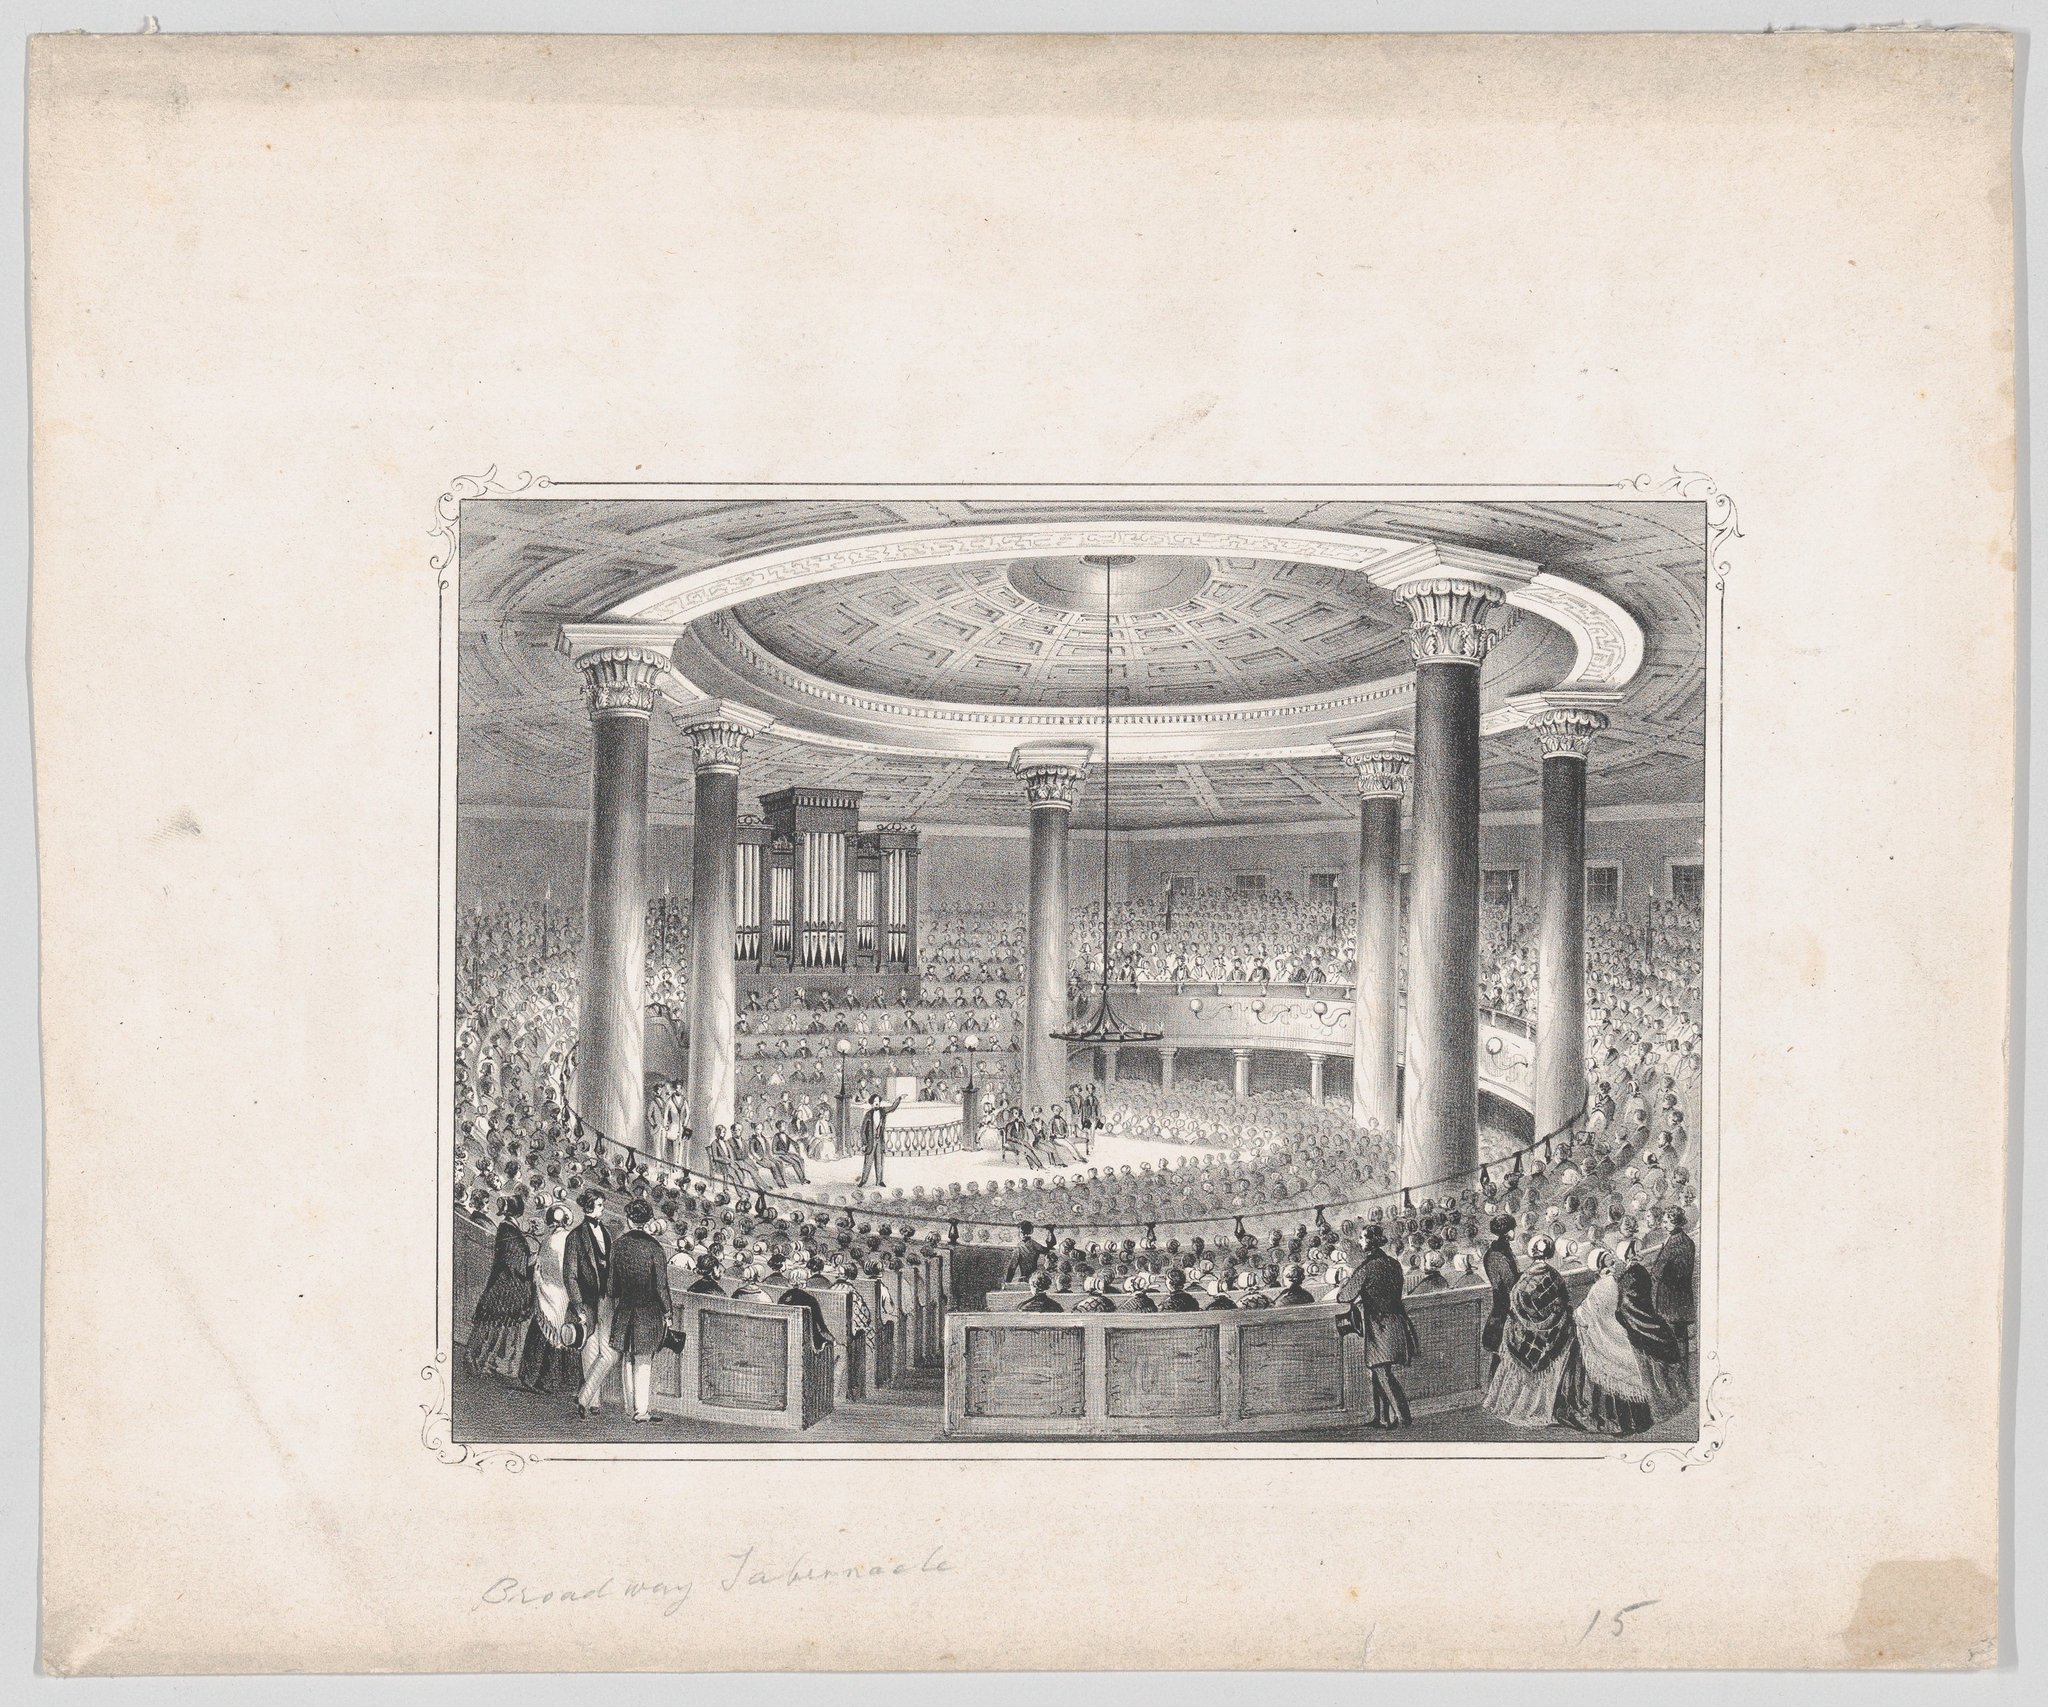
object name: print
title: The Broadway Tabernacle, New York, in Anniversary Week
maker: snyder, black & sturn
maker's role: printer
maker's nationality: american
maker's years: 1850-1900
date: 1856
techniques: lithograph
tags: interiors,churches,crowd